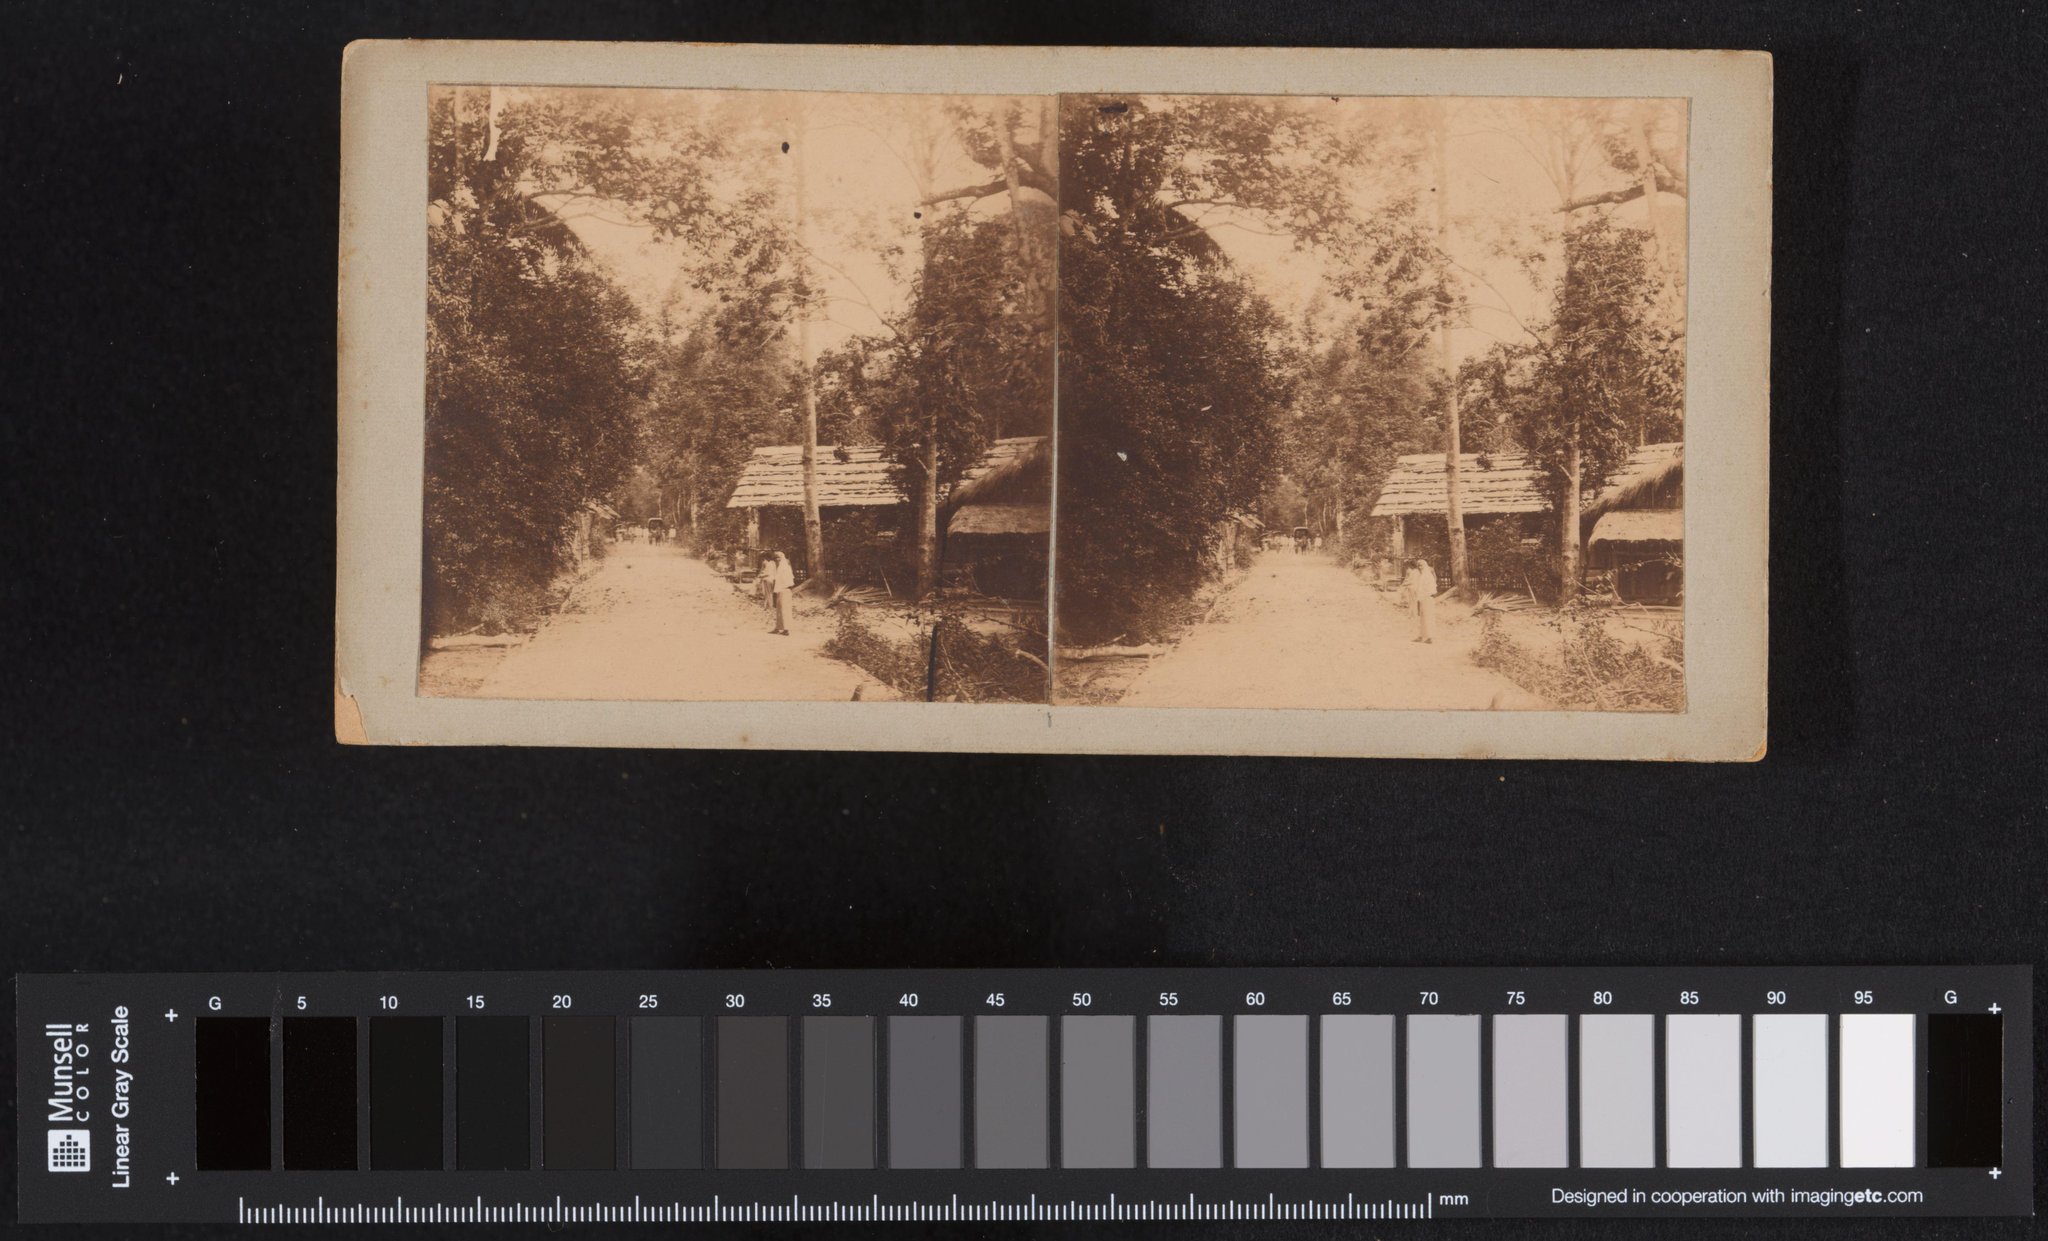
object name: stereograph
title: Weg bij Soengeiliat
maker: robert julius boers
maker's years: 1867-1932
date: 1900-1922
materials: cardboard, photographic support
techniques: gelatin silver print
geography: bangka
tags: robert julius boers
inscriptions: inscription: ‘Duri ang (Soengeiliat)’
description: Huizen aan een weg bij Soengeiliat op Banka. Onderdeel van een groep stereofoto's van Robert Julius Boers, chef van het staatsbedrijf de Banka-tinwinning op Banka, uit de periode ca. 1900-1922.